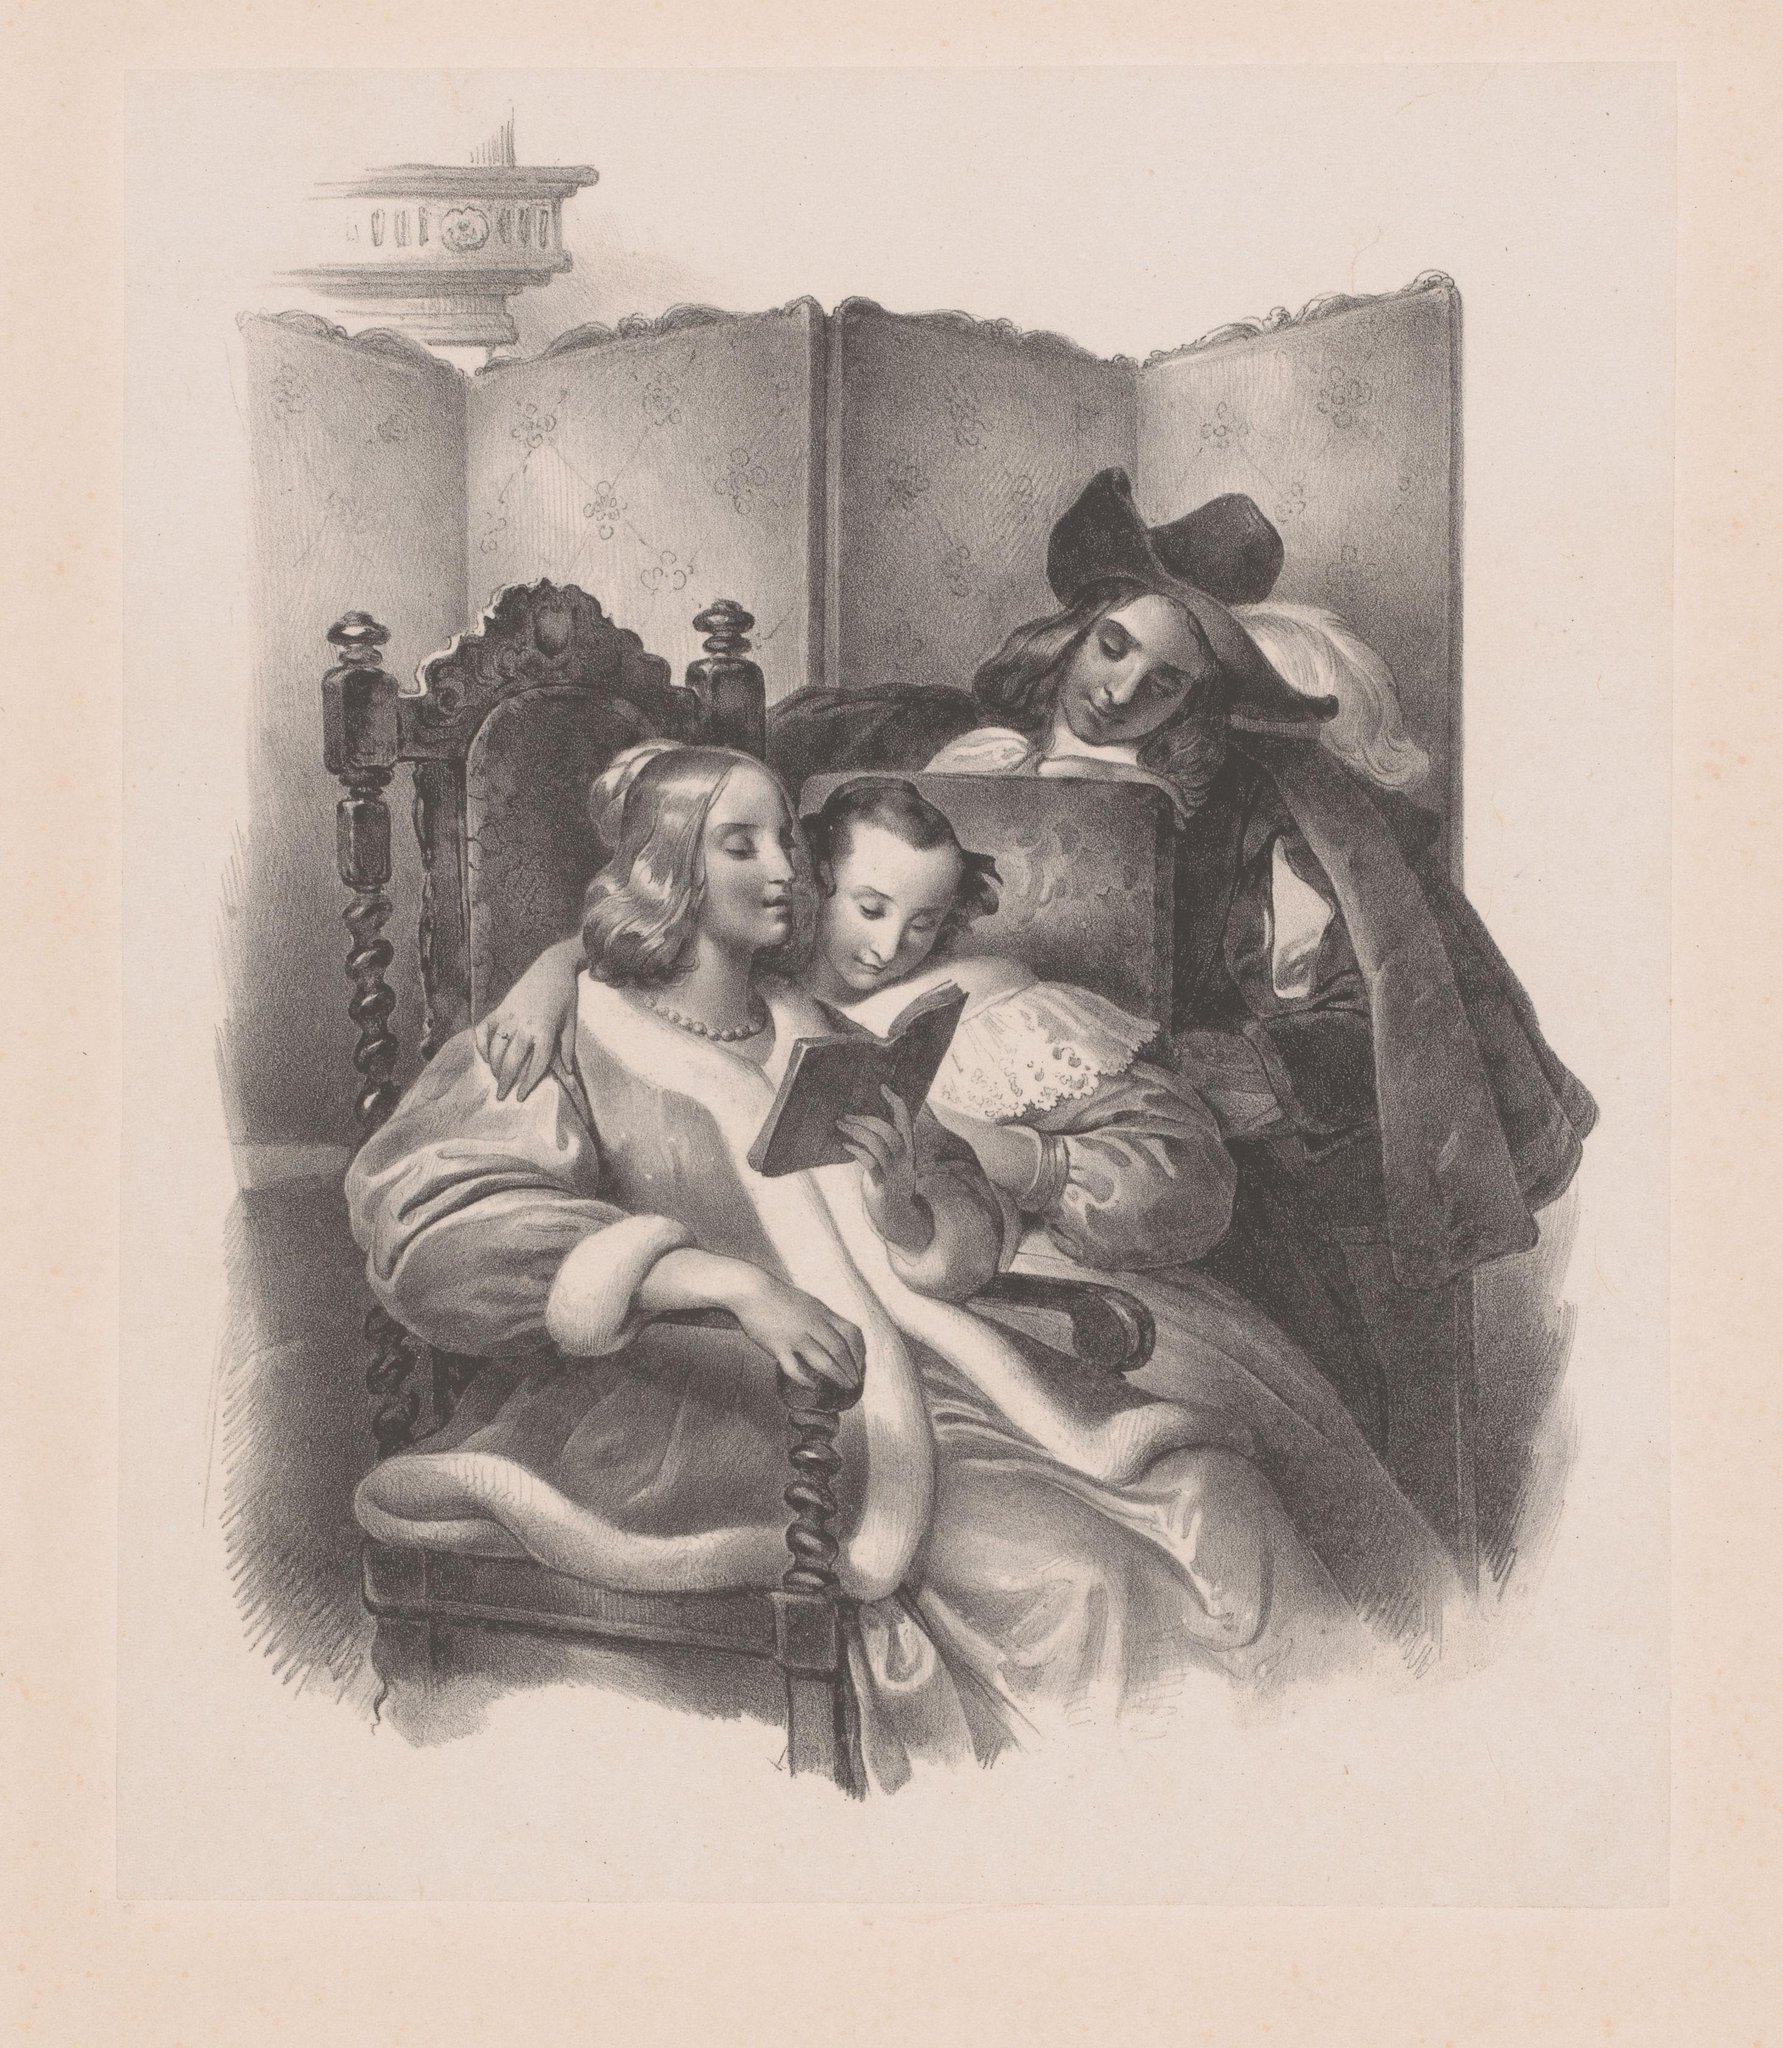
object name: print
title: Lezende vrouw met jongen en meisje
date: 1833-1863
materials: paper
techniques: lithograph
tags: reading to somebody, screen, folding screen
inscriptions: collector's mark: Lugt 2228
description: De vrouw en het meisje zitten in een stoel, de jongen staat ernaast. Achter hen een kamerscherm.